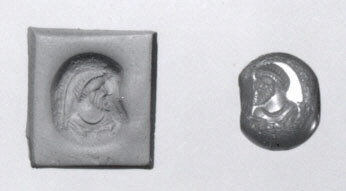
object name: stamp seal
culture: sasanian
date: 201-700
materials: gemstone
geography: iran or mesopotamia